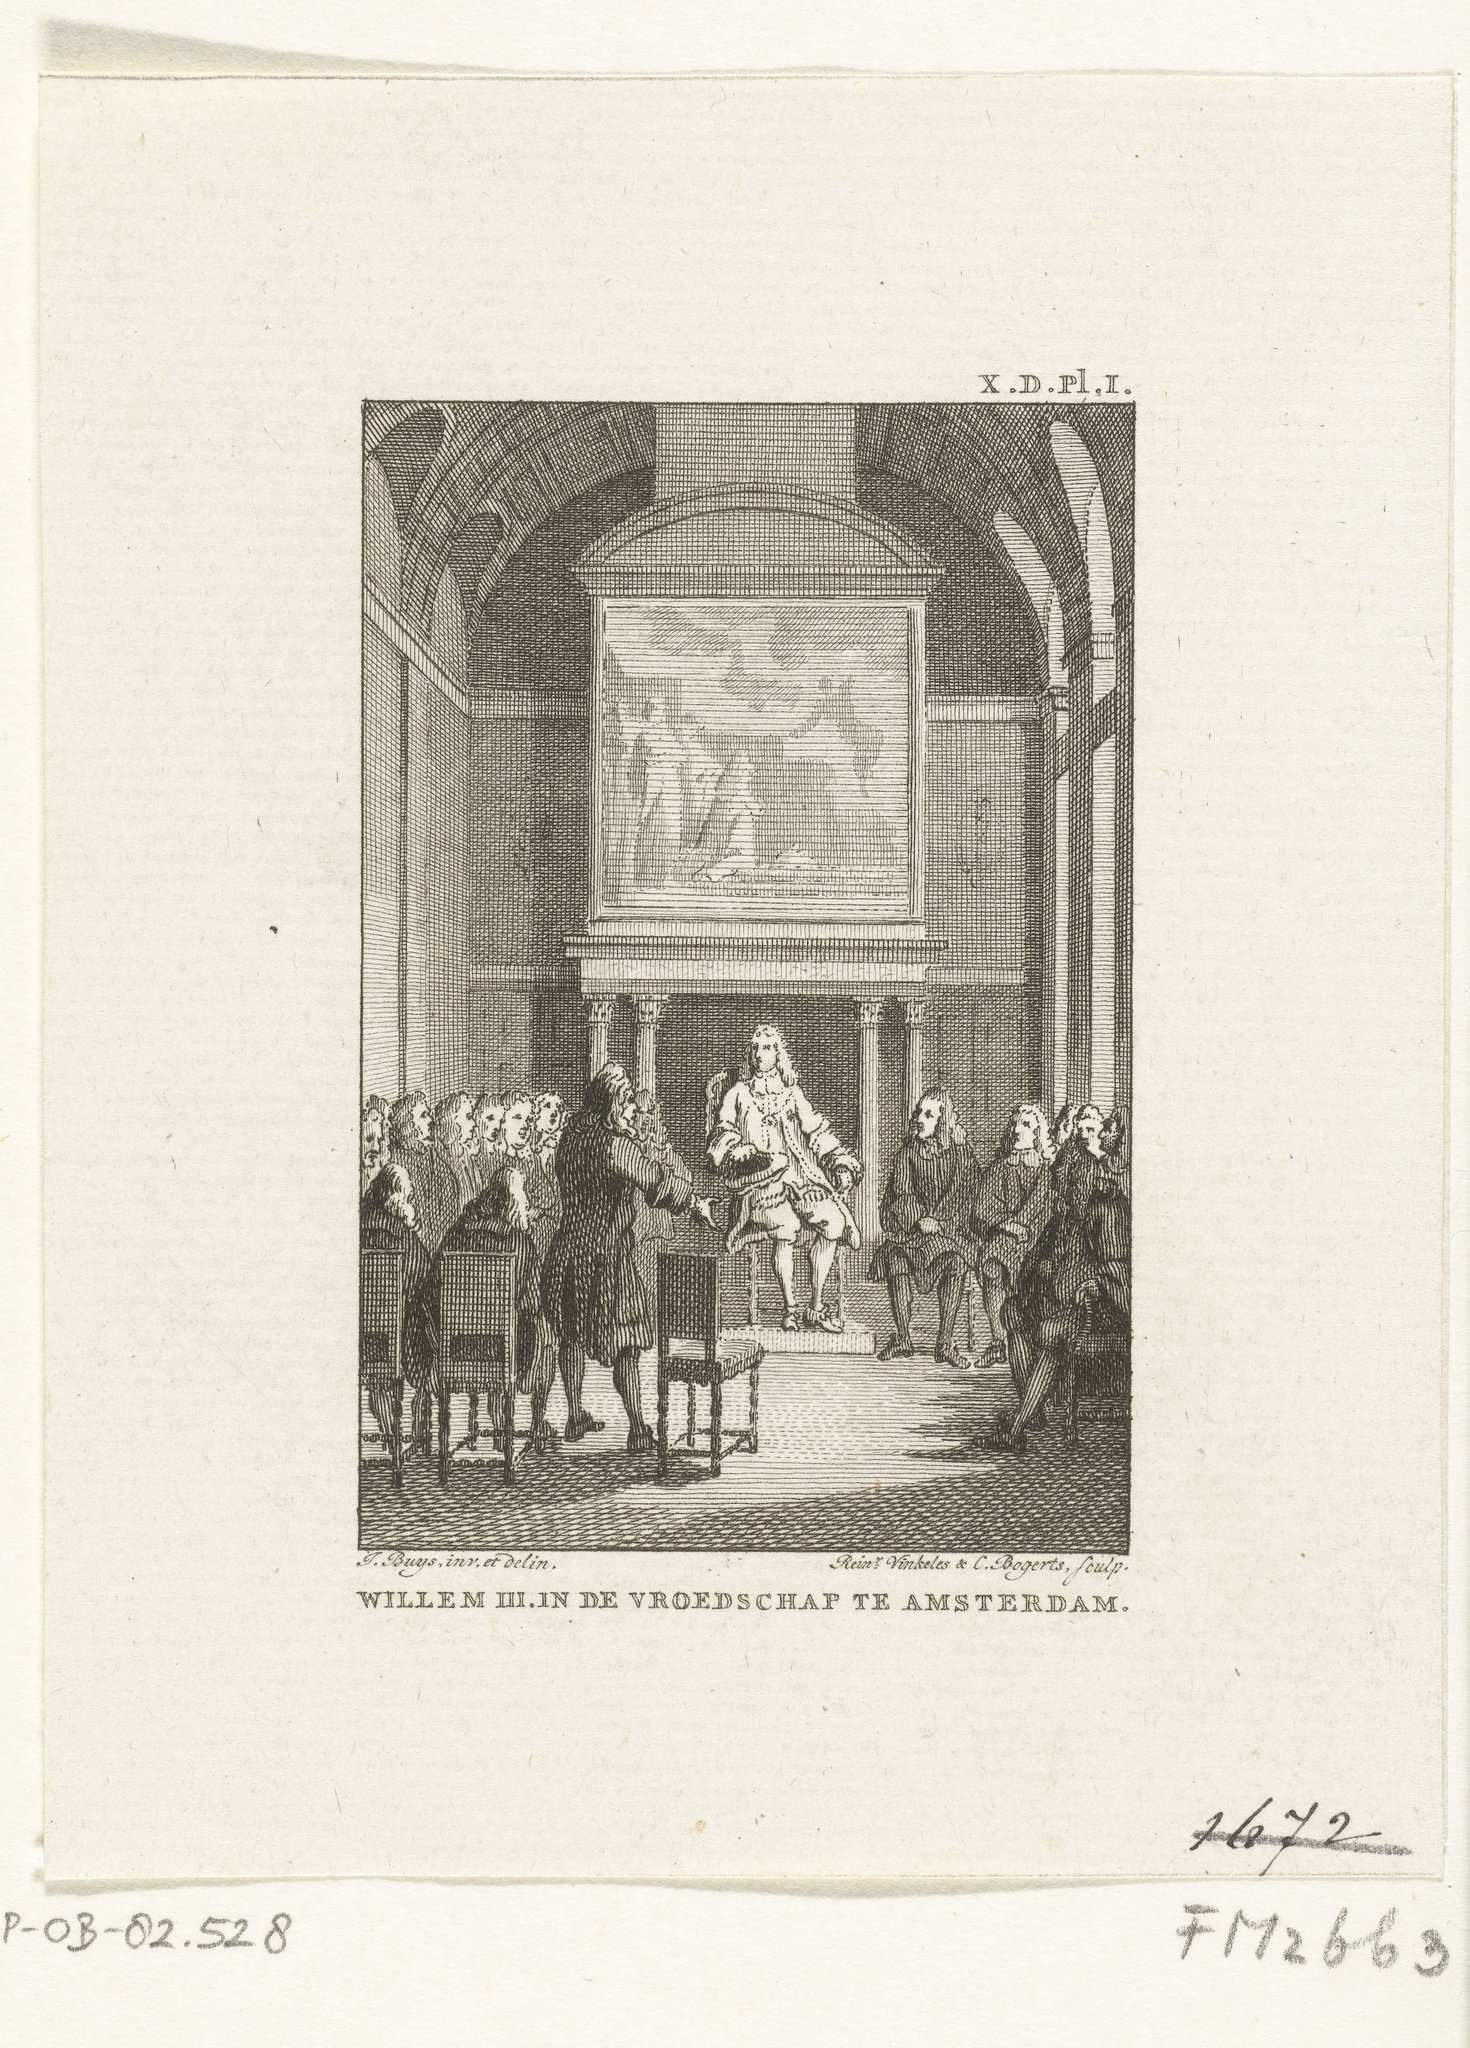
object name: history print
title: Willem III. in de vroedschap te Amsterdam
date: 1780-1795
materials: paper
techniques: etching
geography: northern netherlands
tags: the hague, william iii (prince of orange and king of england, scotland, and ireland), meeting, assembly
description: Gebruikt als illustratie in: J. Fokke, Geschiedenissen der Vereenigde Nederlanden voor de vaderlandsche jeugd, Johannes Allart, Amsterdam 1783-1795, 25 delen, dl. X, pl. I.